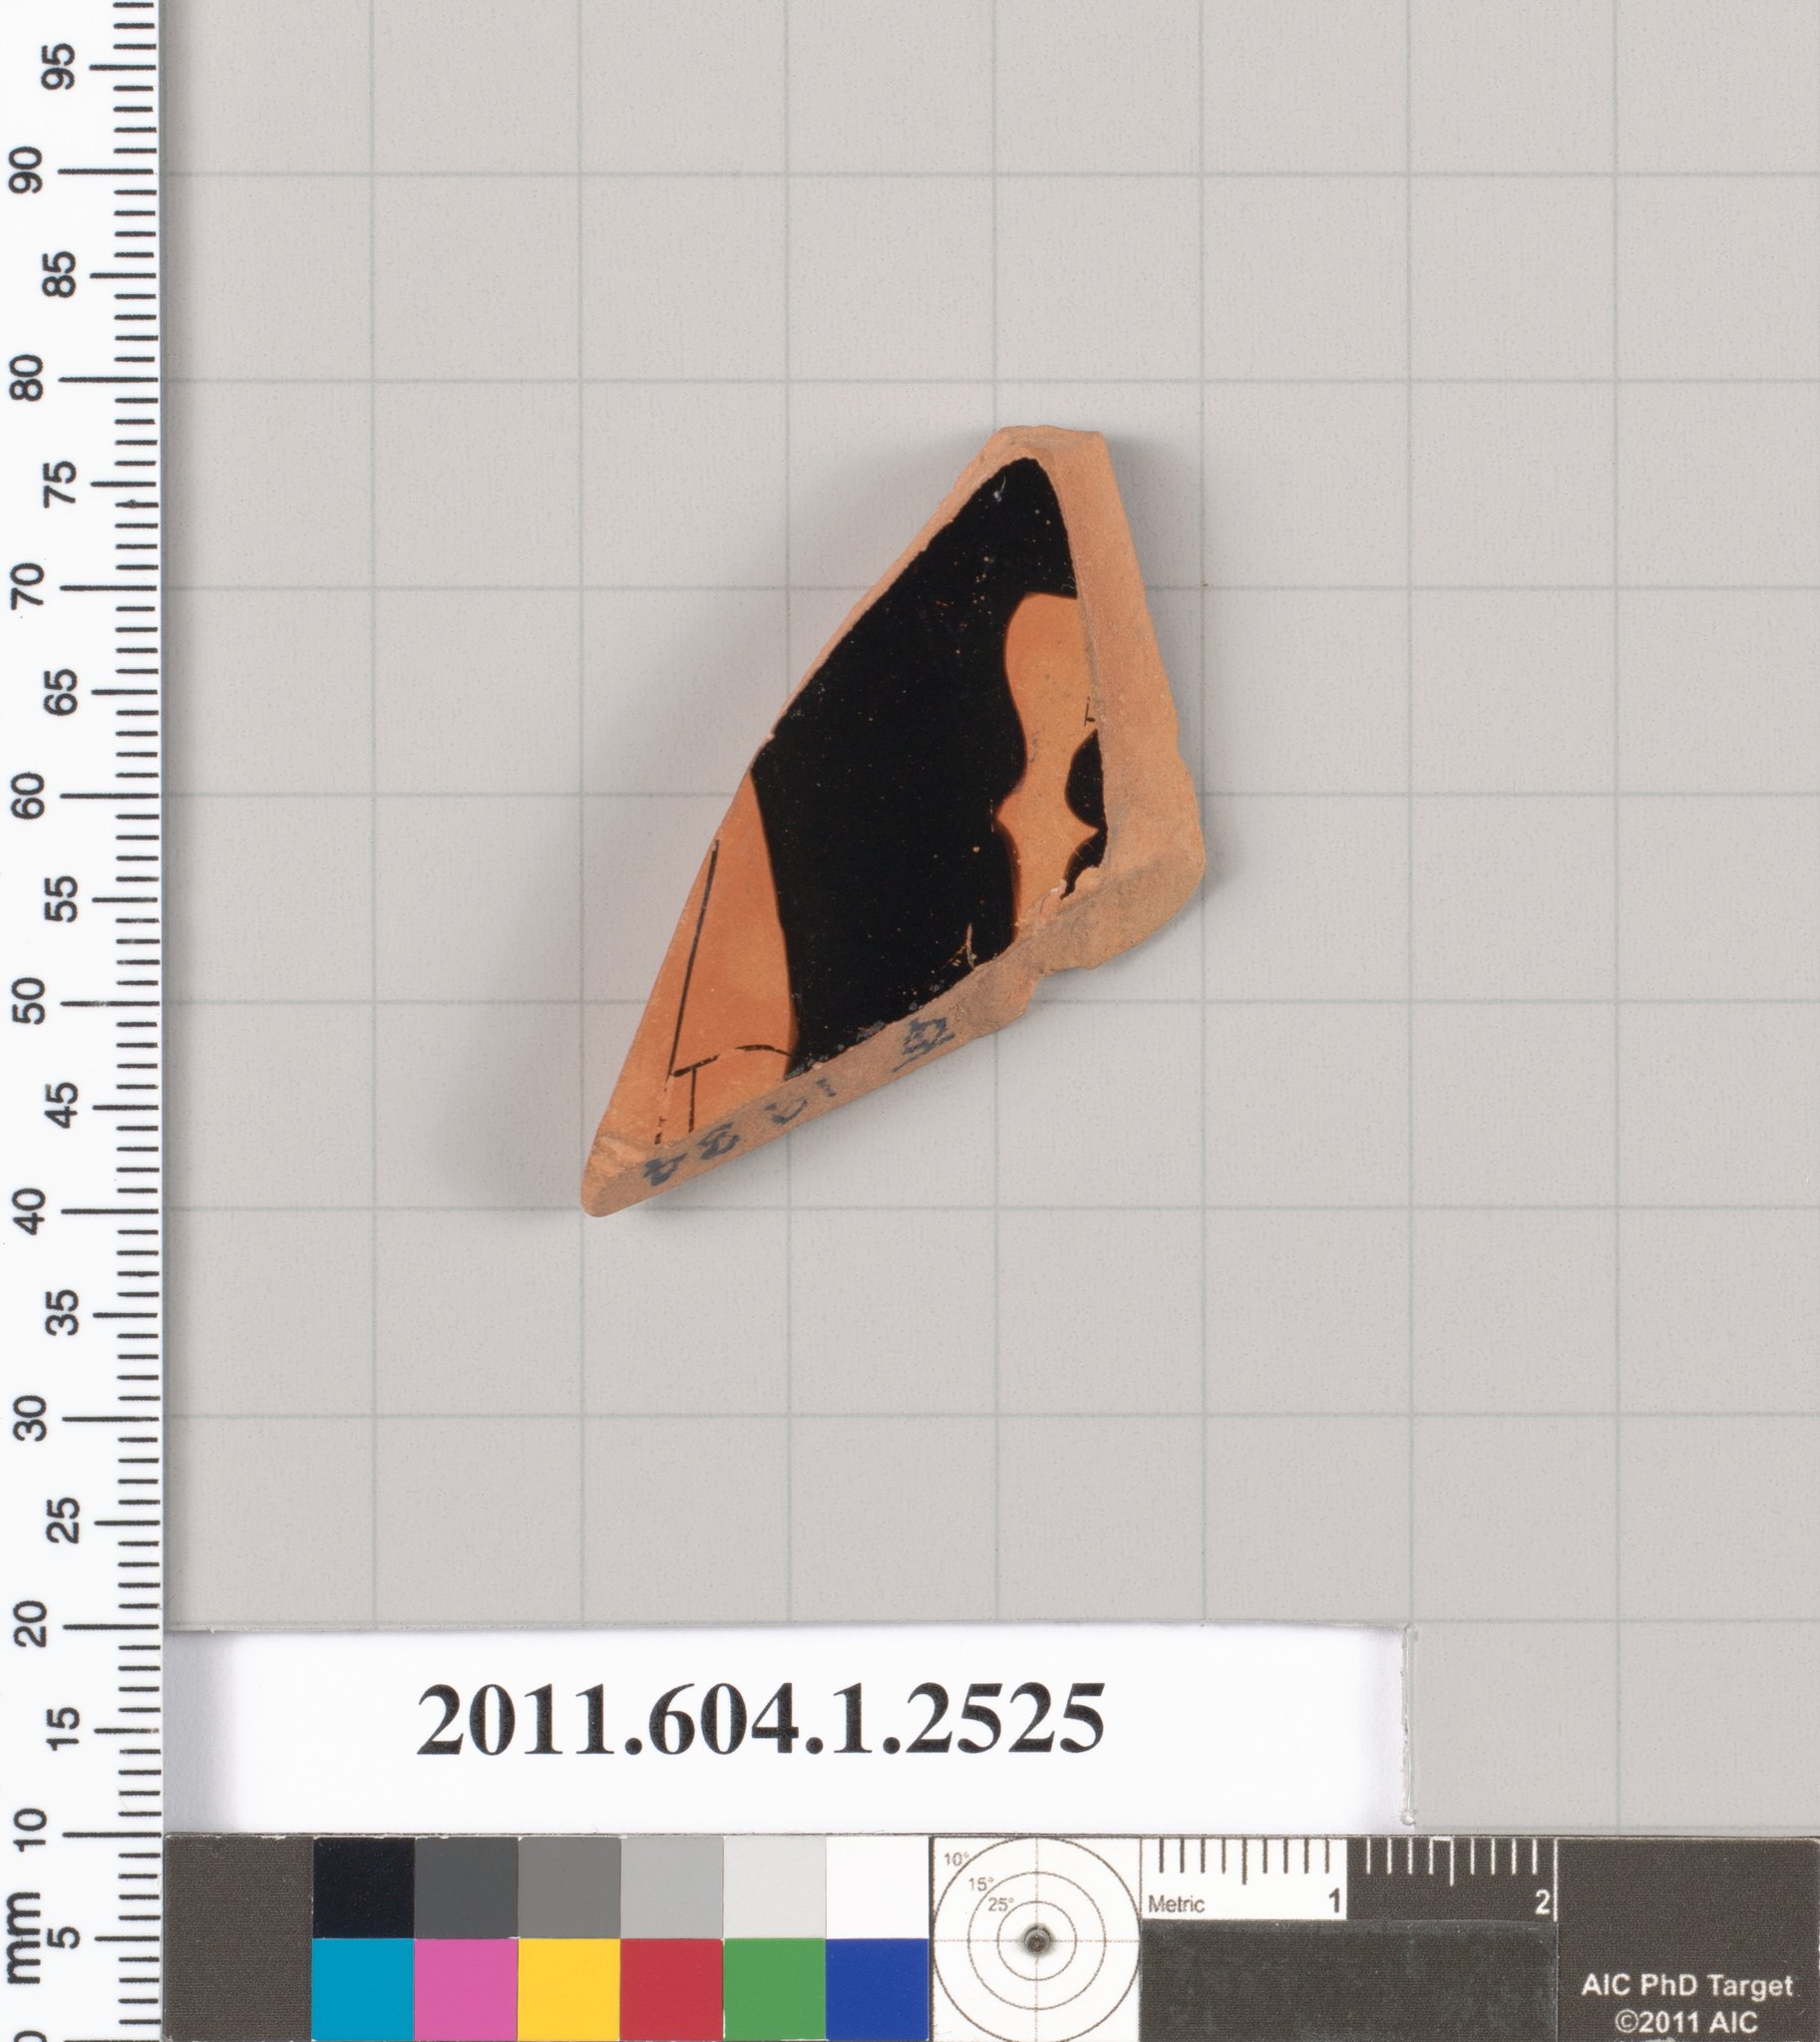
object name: kylix fragment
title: Terracotta fragment of a kylix (drinking cup)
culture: greek, attic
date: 475-451 BCE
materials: terracotta